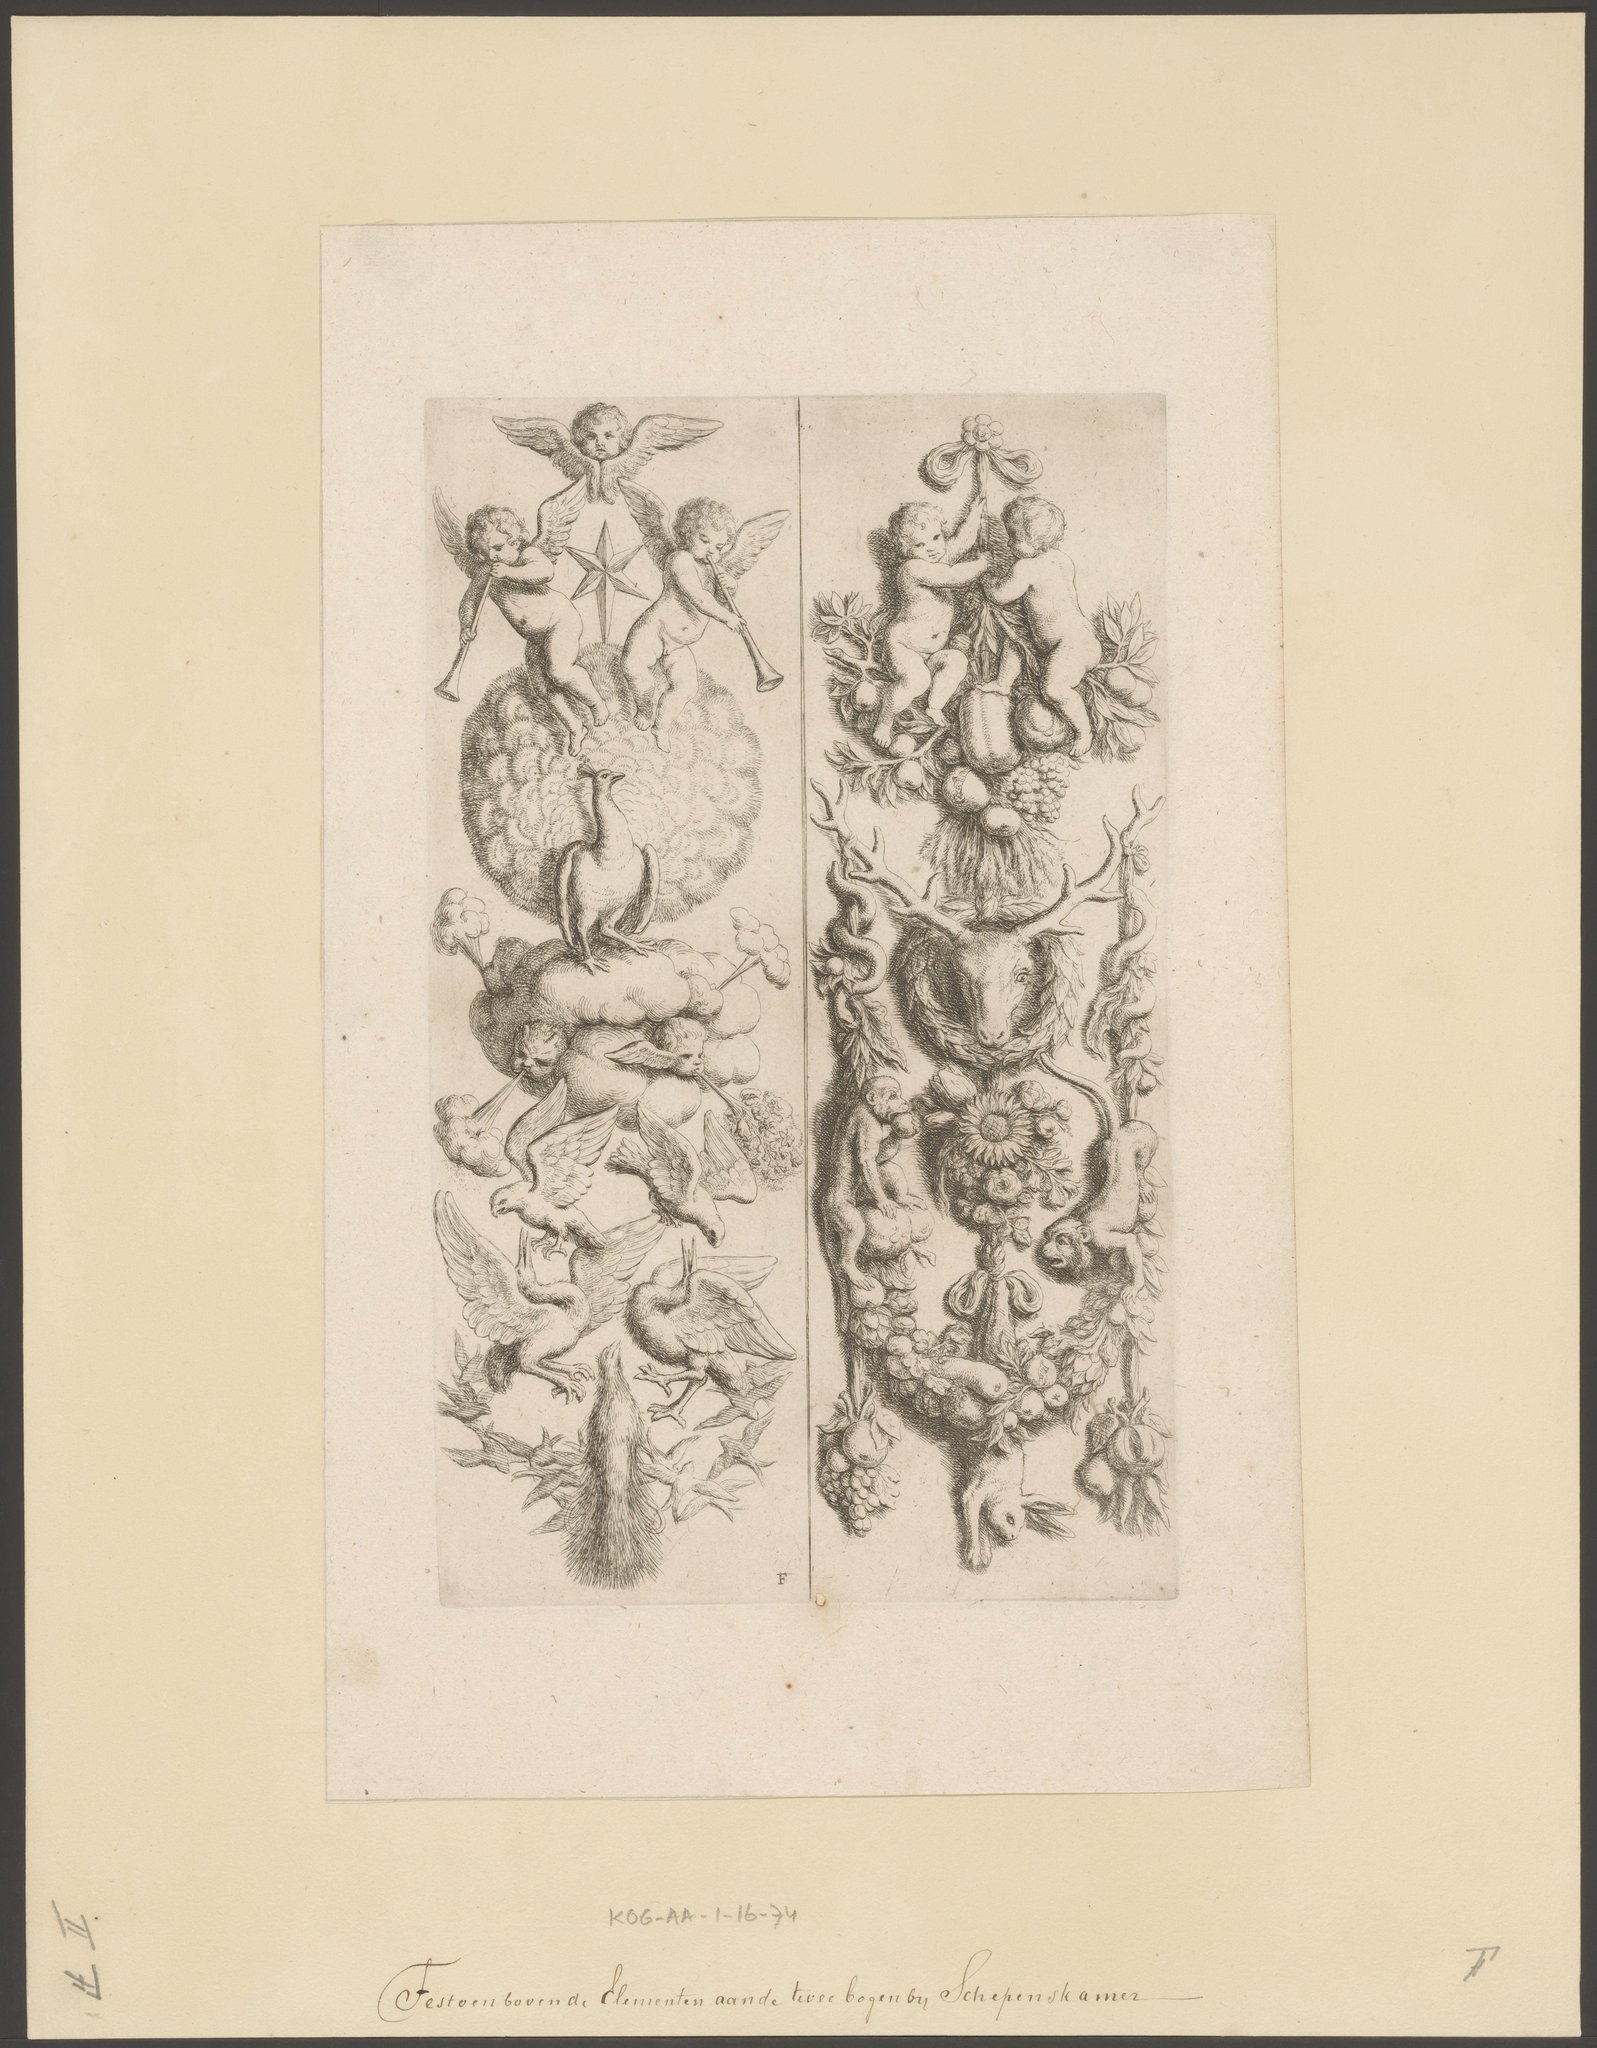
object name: print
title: Festoenen met attributen van de personificaties van de elementen Lucht en Aarde aan oostzijde van de Burgerzaal in het Stadhuis op de Dam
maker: hubert quellinus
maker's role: print maker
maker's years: 1619-1687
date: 1663-1668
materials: paper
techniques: engraving, etching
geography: amsterdam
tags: earth (one of the four elements), air (one of the four elements), townhall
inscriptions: collector's mark: ‘16,74’ Lugt 1641b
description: Huidige staat van prent ook gebruikt in: Secunca pars Praecipuarum effigierum ac ornamentorum amplissime Curiae Amstelrodamensis maiori ex parte in cadido marmore effectorum per Artum Quellinium eiusdem Civitatis Statuarium / Het tweede deel Van de voornaemste Statuen ende Cieraten van 't konst-rijcke Stadt-huys van Amstelredam 'tmeeste in Marmer gemaeckt door Artus Quellinus Beelthouwer der voorseyde Stadt. Amsterdam: Artus Quellinus (I), 1663. En in: Secunca pars Praecipuarum effigierum ac ornamentorum amplissime Curiae Amstelrodamensis maiori ex parte in cadido marmore effectorum per Artum Quellinium eiusdem Civitatis Statuarium / Het tweede deel Van de voornaemste Statuen ende Cieraten van 't konst-rijcke Stadt-huys van Amstelredam 'tmeeste in Marmer gemaeckt door Artus Quellinus Beelthouwer der voorseyde Stadt. Amsterdam: Frederik de Wit, 1668. Latere staat van prent ook gebruikt in: Architecture peinture et sculpture de la Maison de Ville d'Amsterdam, representee en CIX. figures en taille-douce (…). Amsterdam: David Mortier, 1719. En in: Architecture peinture et sculpture de la Maison de Ville d'Amsterdam, representee en CIX. figures en taille-douce (…). Amsterdam: Gerard Valck, 1719. En in: Bouw schilder en beeldhouwkonst, van het Stadhuis te Amsteldam, vertoont in CIX figuuren (…). Amsterdam: Covens & Mortier & Covens Jr., s.a. (1774-1783).